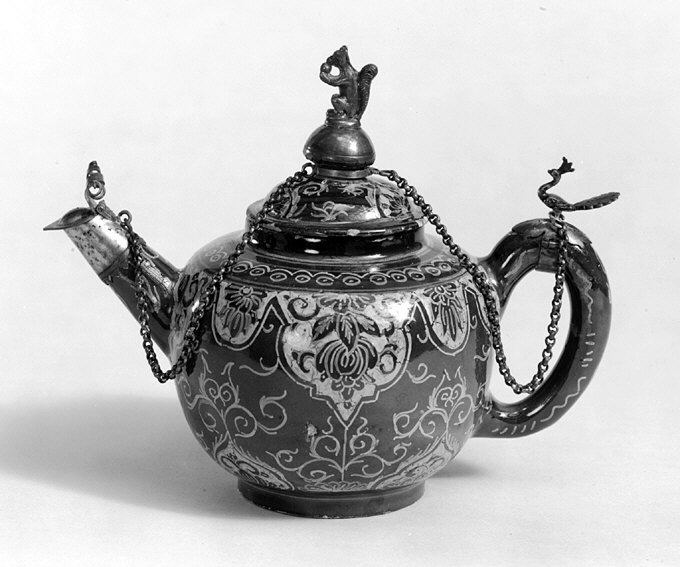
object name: teapot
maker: het jonge moriaenshooft factory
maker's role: maker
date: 1692-1730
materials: earthenware, silver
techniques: glazing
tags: animals,peacocks